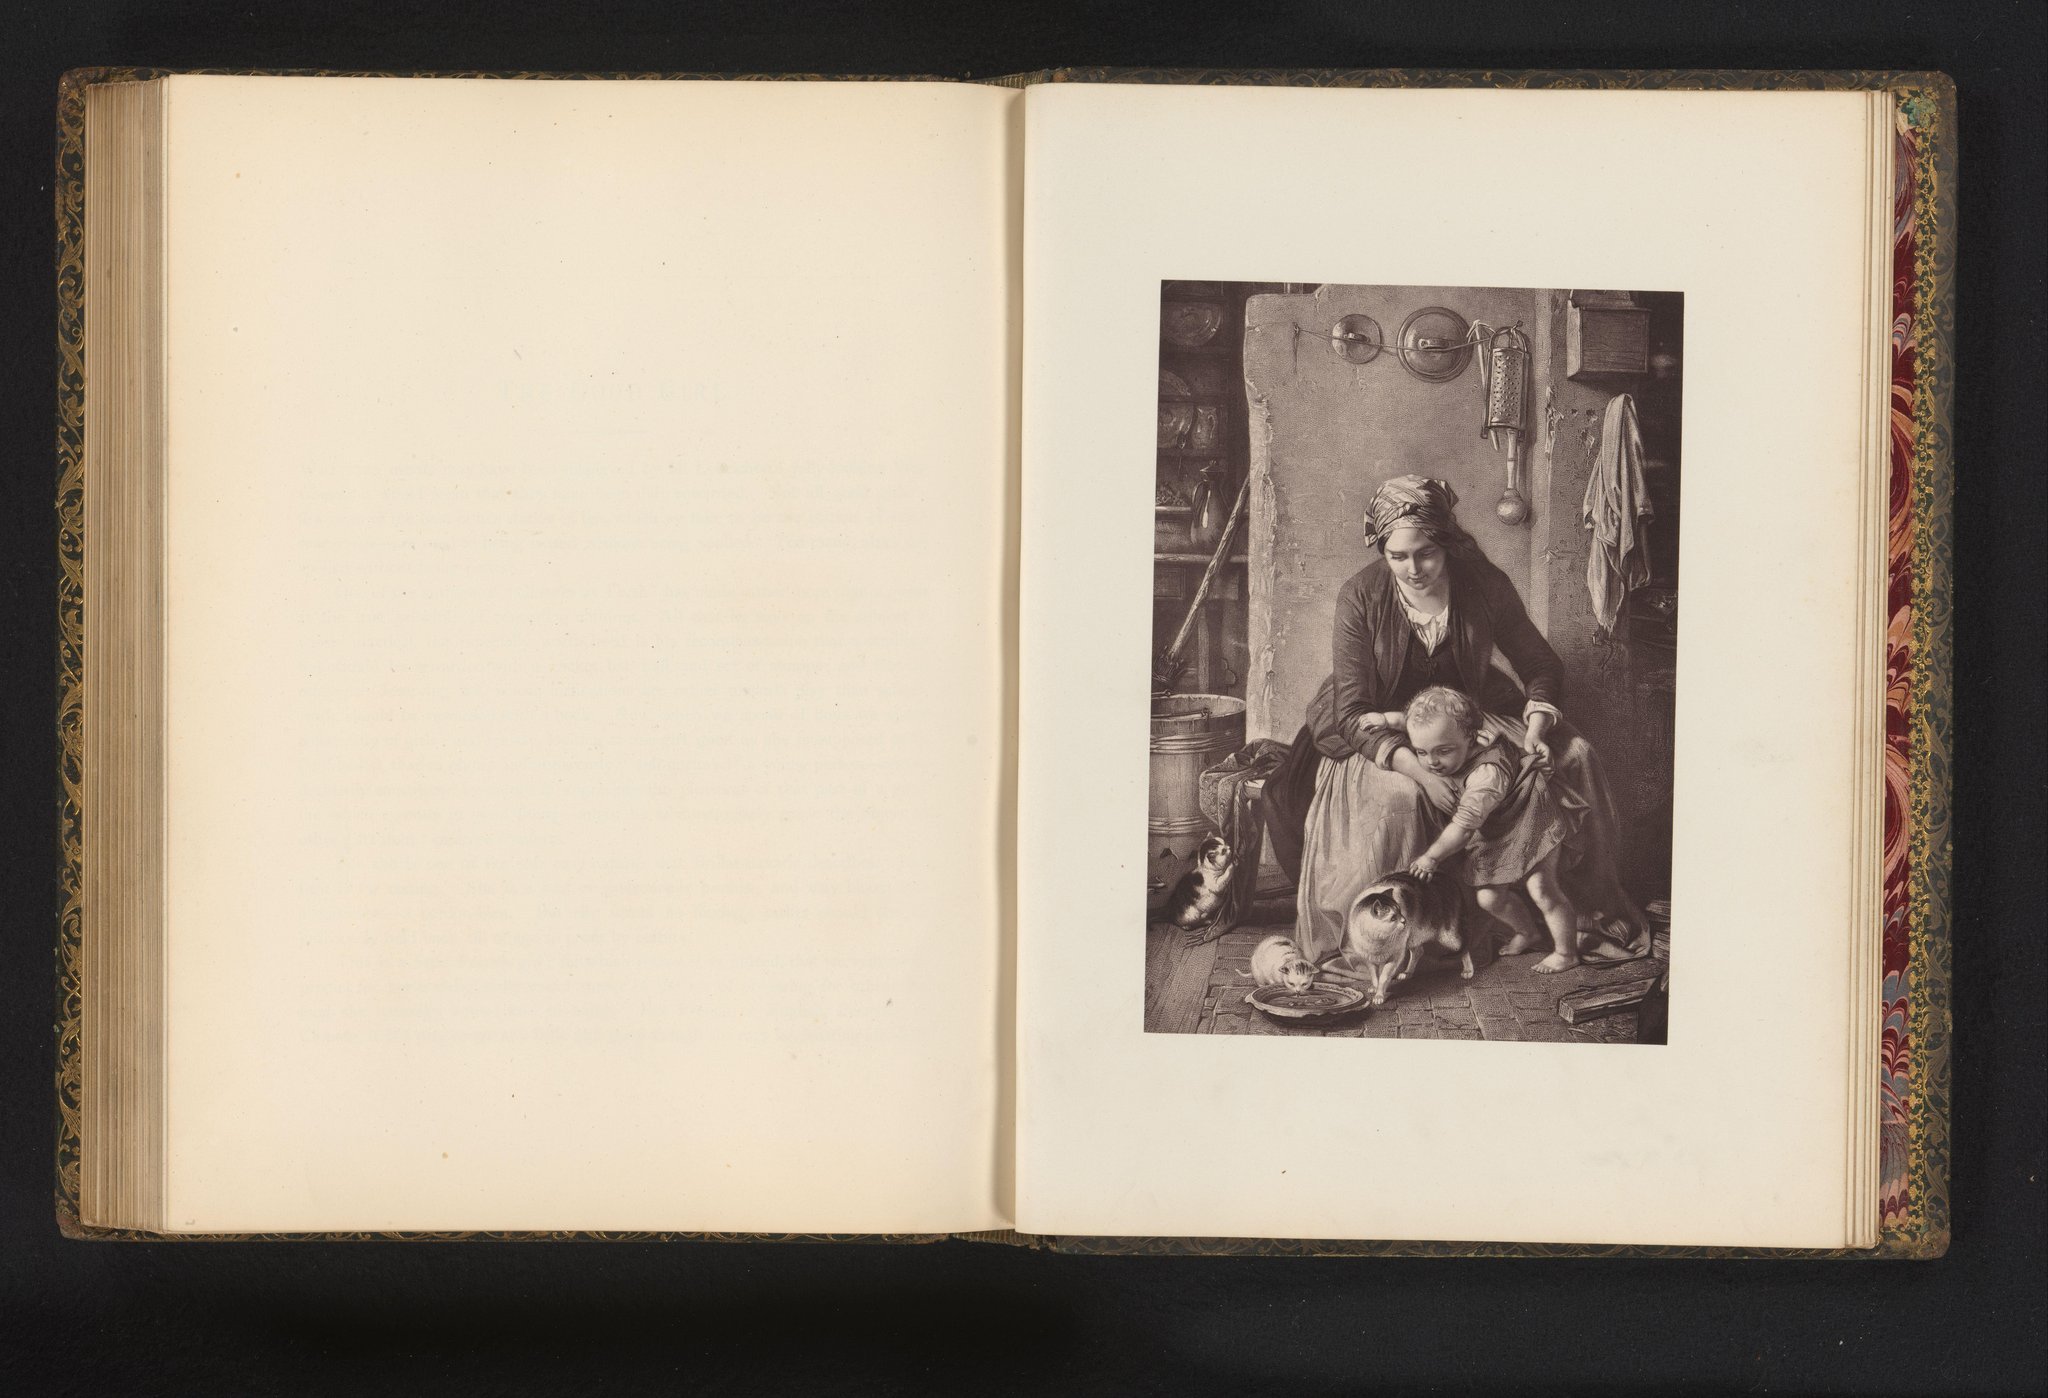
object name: reproduction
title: Fotoreproductie van een gravure naar een schilderij van moeder met kind en poezen in keuken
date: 1866-1871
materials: paper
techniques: woodburytype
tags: kitchen, print, e.g.: engraving, etching, lithograph, family life at home, mother and baby or young child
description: Prent op derde ongenummerde pagina na pagina 122.